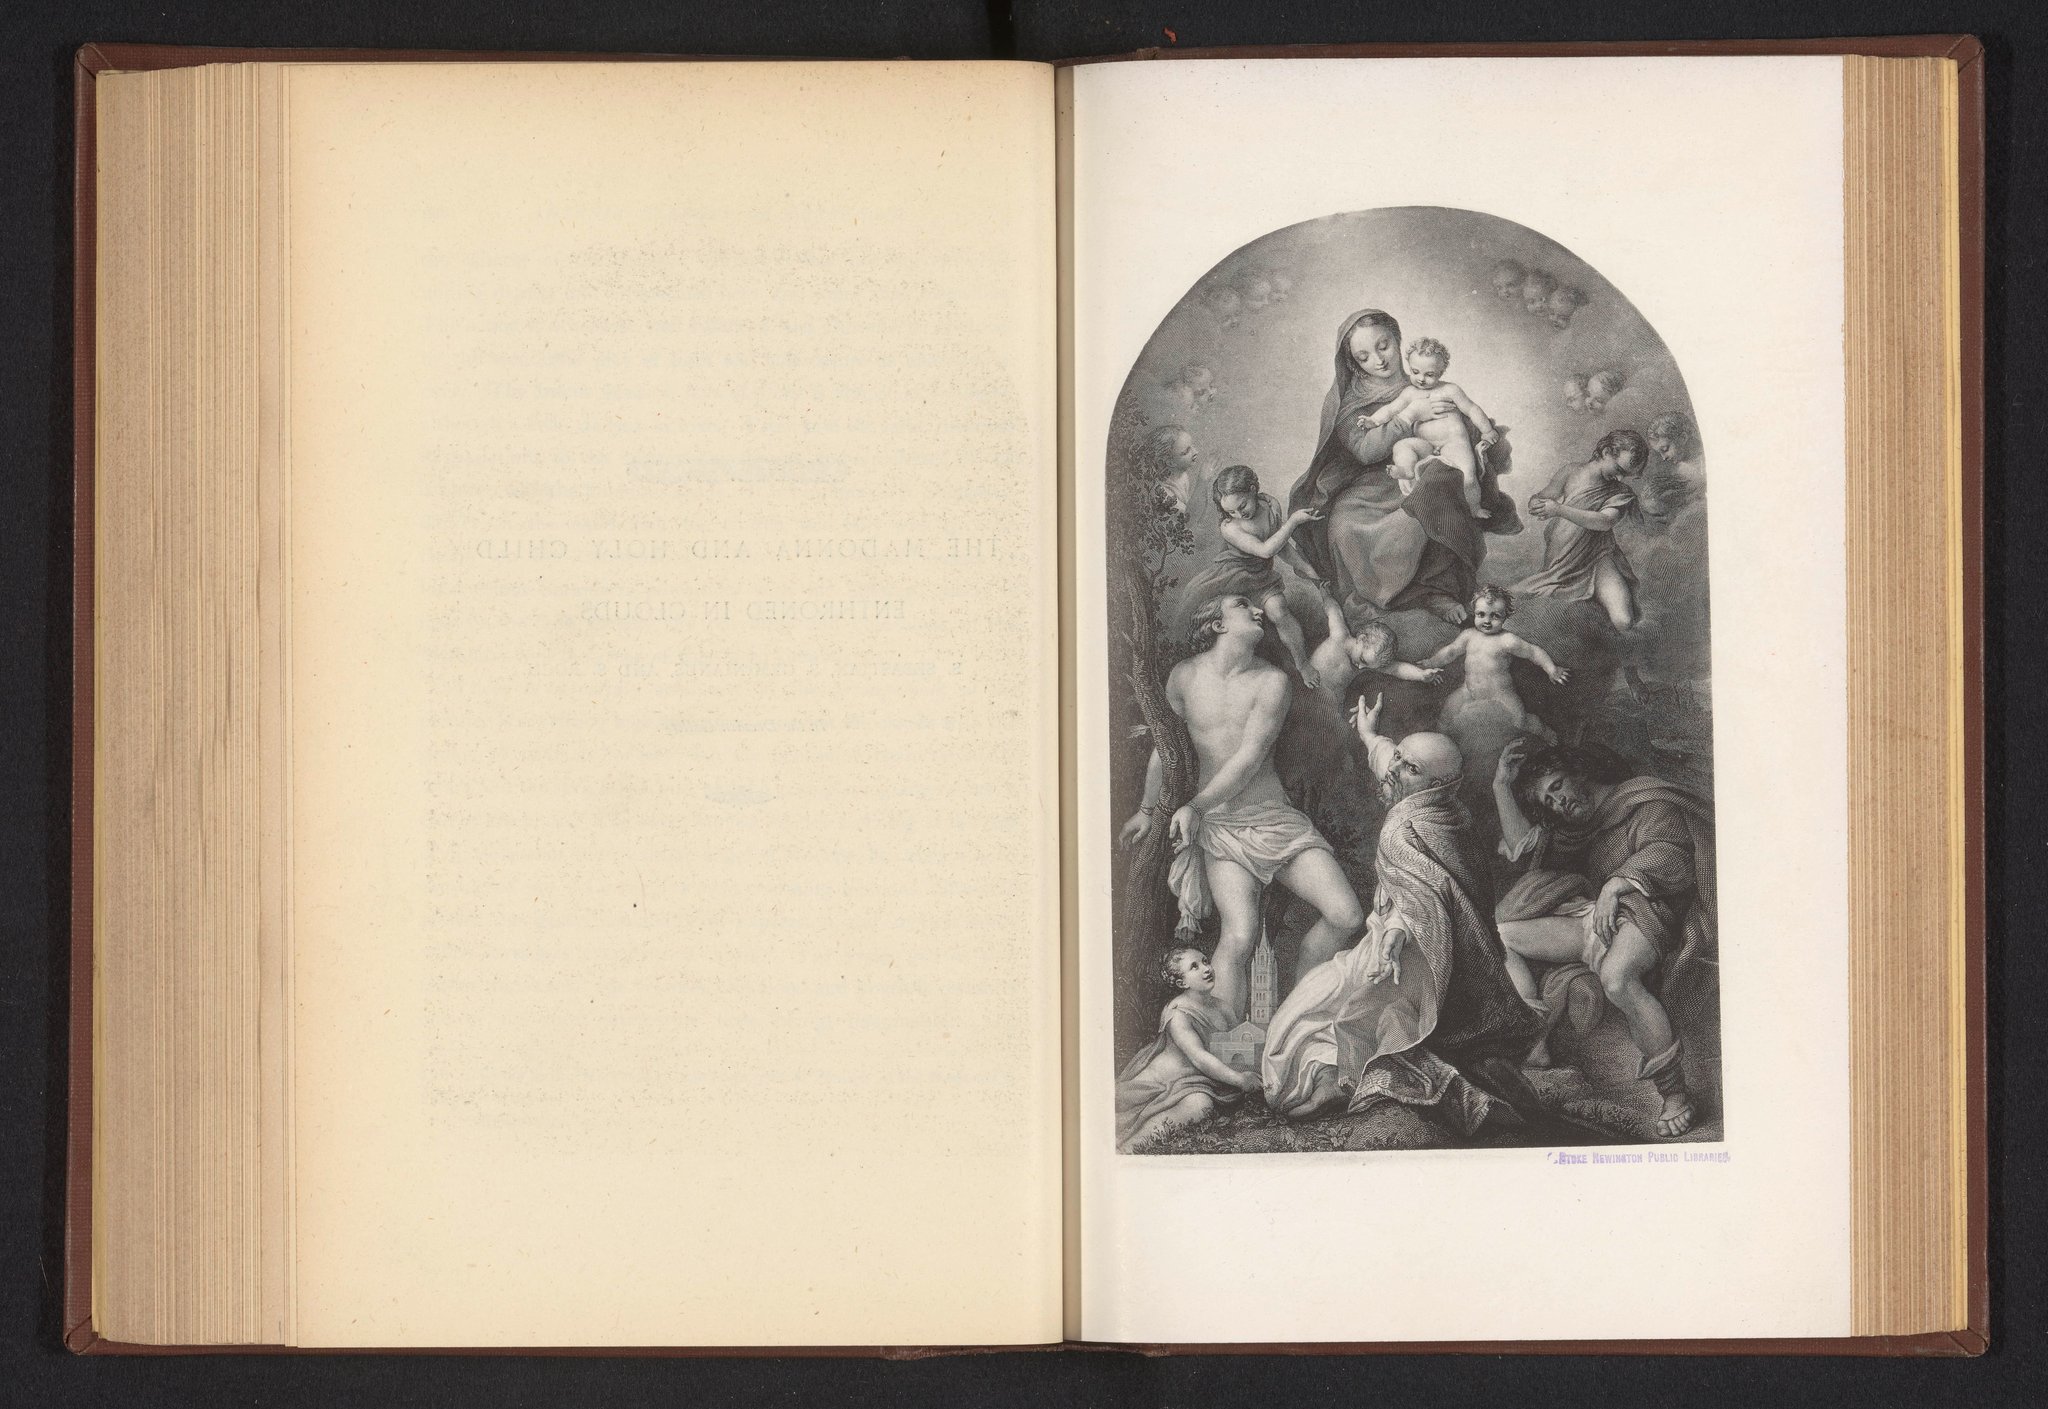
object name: reproduction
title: Fotoreproductie van een prent naar een schilderij, voorstellende de tronende Madonna met de heilige Sebastiaan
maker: Anonymous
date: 1870-1876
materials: paper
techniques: photograph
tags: madonna: mary sitting or enthroned, the christ-child in her lap (or in front of her bosom) (mary sometimes represented half-length), the martyr sebastian; possible attributes: arrow(s), bow, tree-trunk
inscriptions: inscription: ‘Stoke Newington Public Libraries’